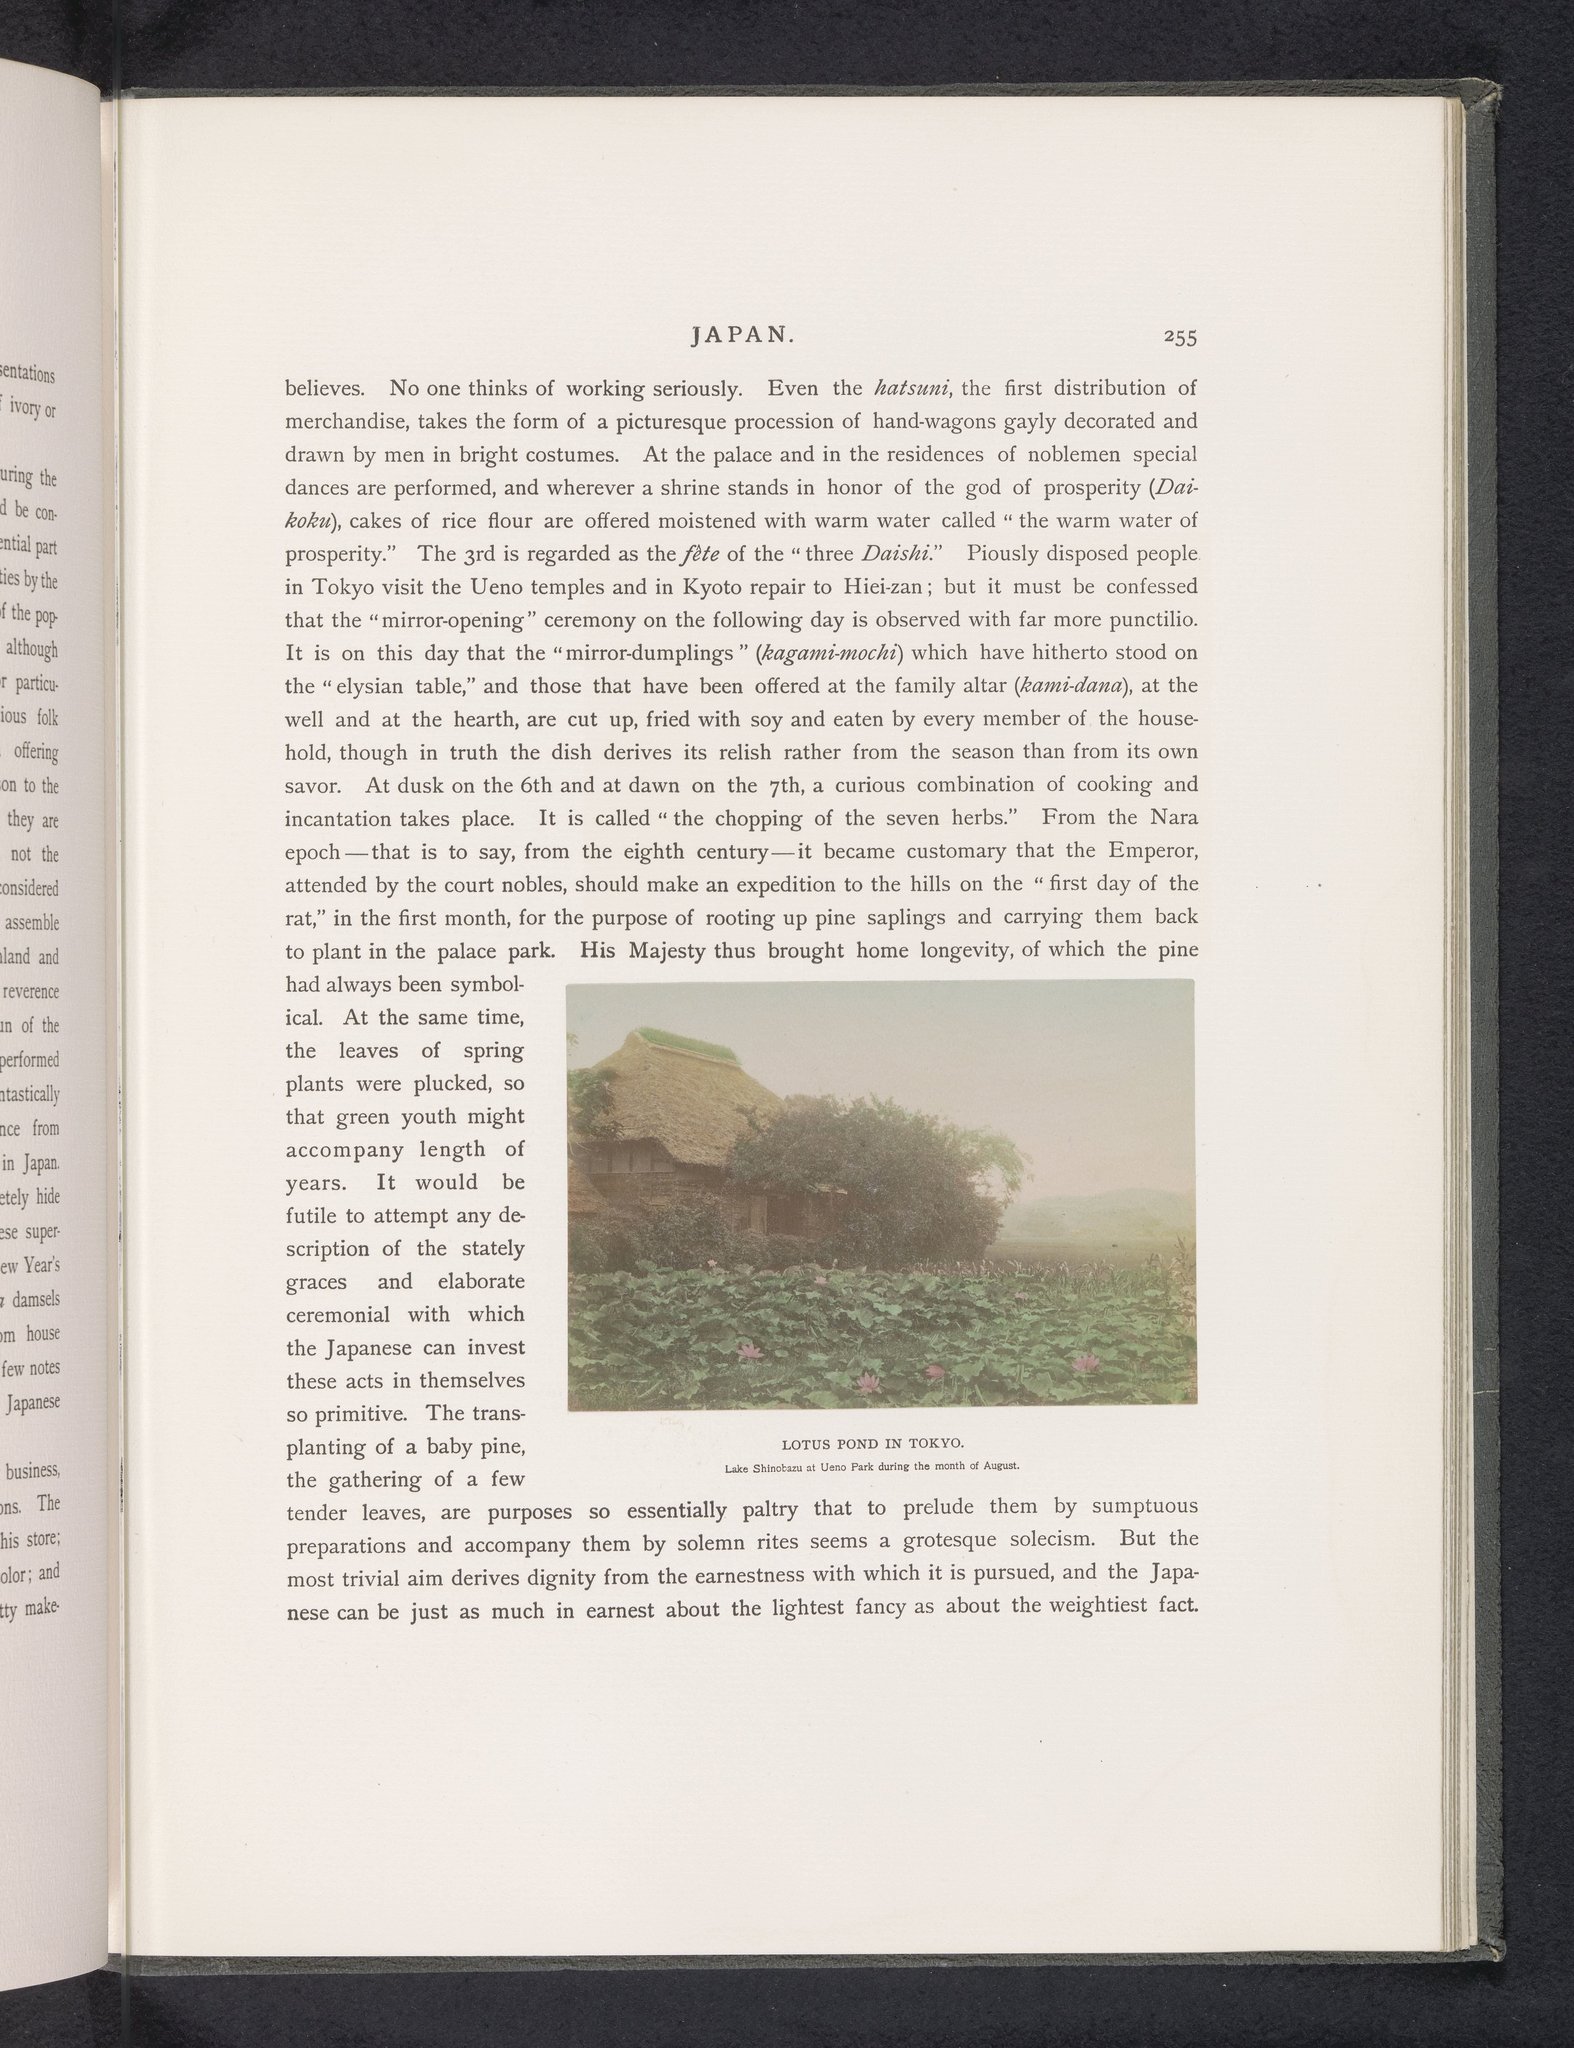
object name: photograph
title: Lotus pond in Tokyo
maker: Anonymous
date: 1887-1897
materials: photographic support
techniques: albumen print, hand coloring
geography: uenopark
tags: pond, pool, flowers: lotus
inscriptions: inscription: ‘Lake Shinobazu at Ueno Park during the month of August.’